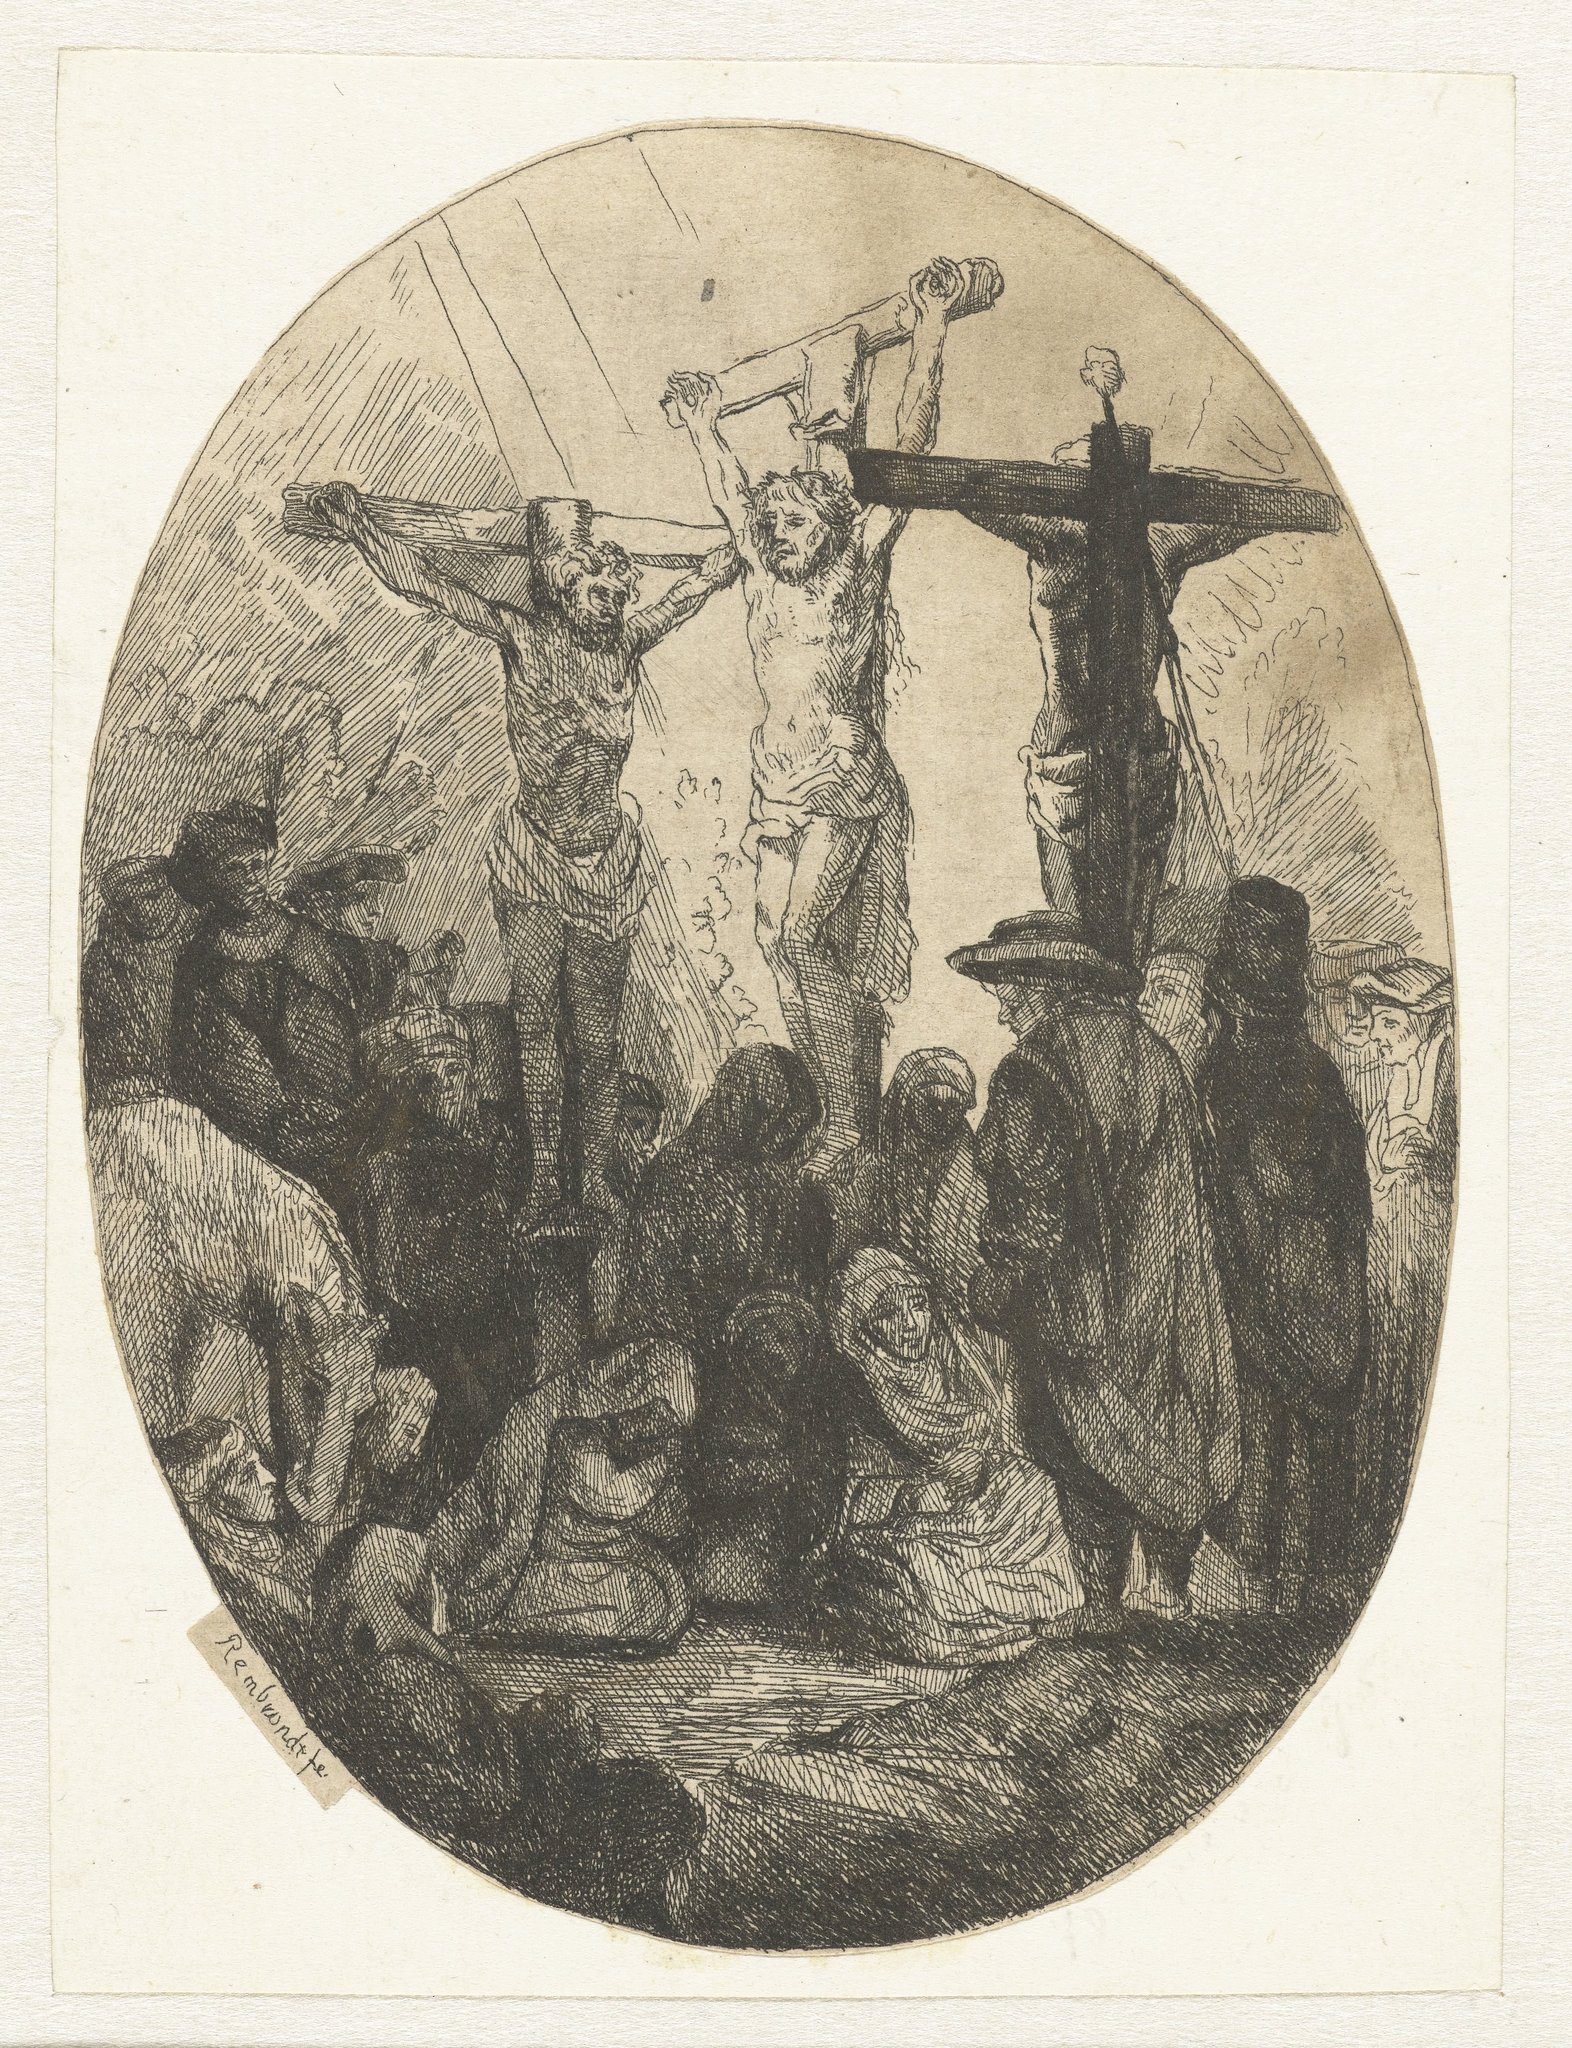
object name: print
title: Christ crucified between the two thieves: an oval plate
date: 1641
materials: paper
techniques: etching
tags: the crucifixion of christ: christ's death on the cross; golgotha (matthew 27:45-58; mark 15:33-45; luke 23:44-52; john 19:25-38)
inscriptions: collector's mark: Lugt 4071, collector's mark: Lugt 1606, collector's mark: Briquet 2760, collector's mark: Lugt 2228, collector's mark: Lugt 2482, collector's mark: Lugt 2434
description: Spiegelbeeldige kopie naar de gelijknamige prent van Rembrandt.